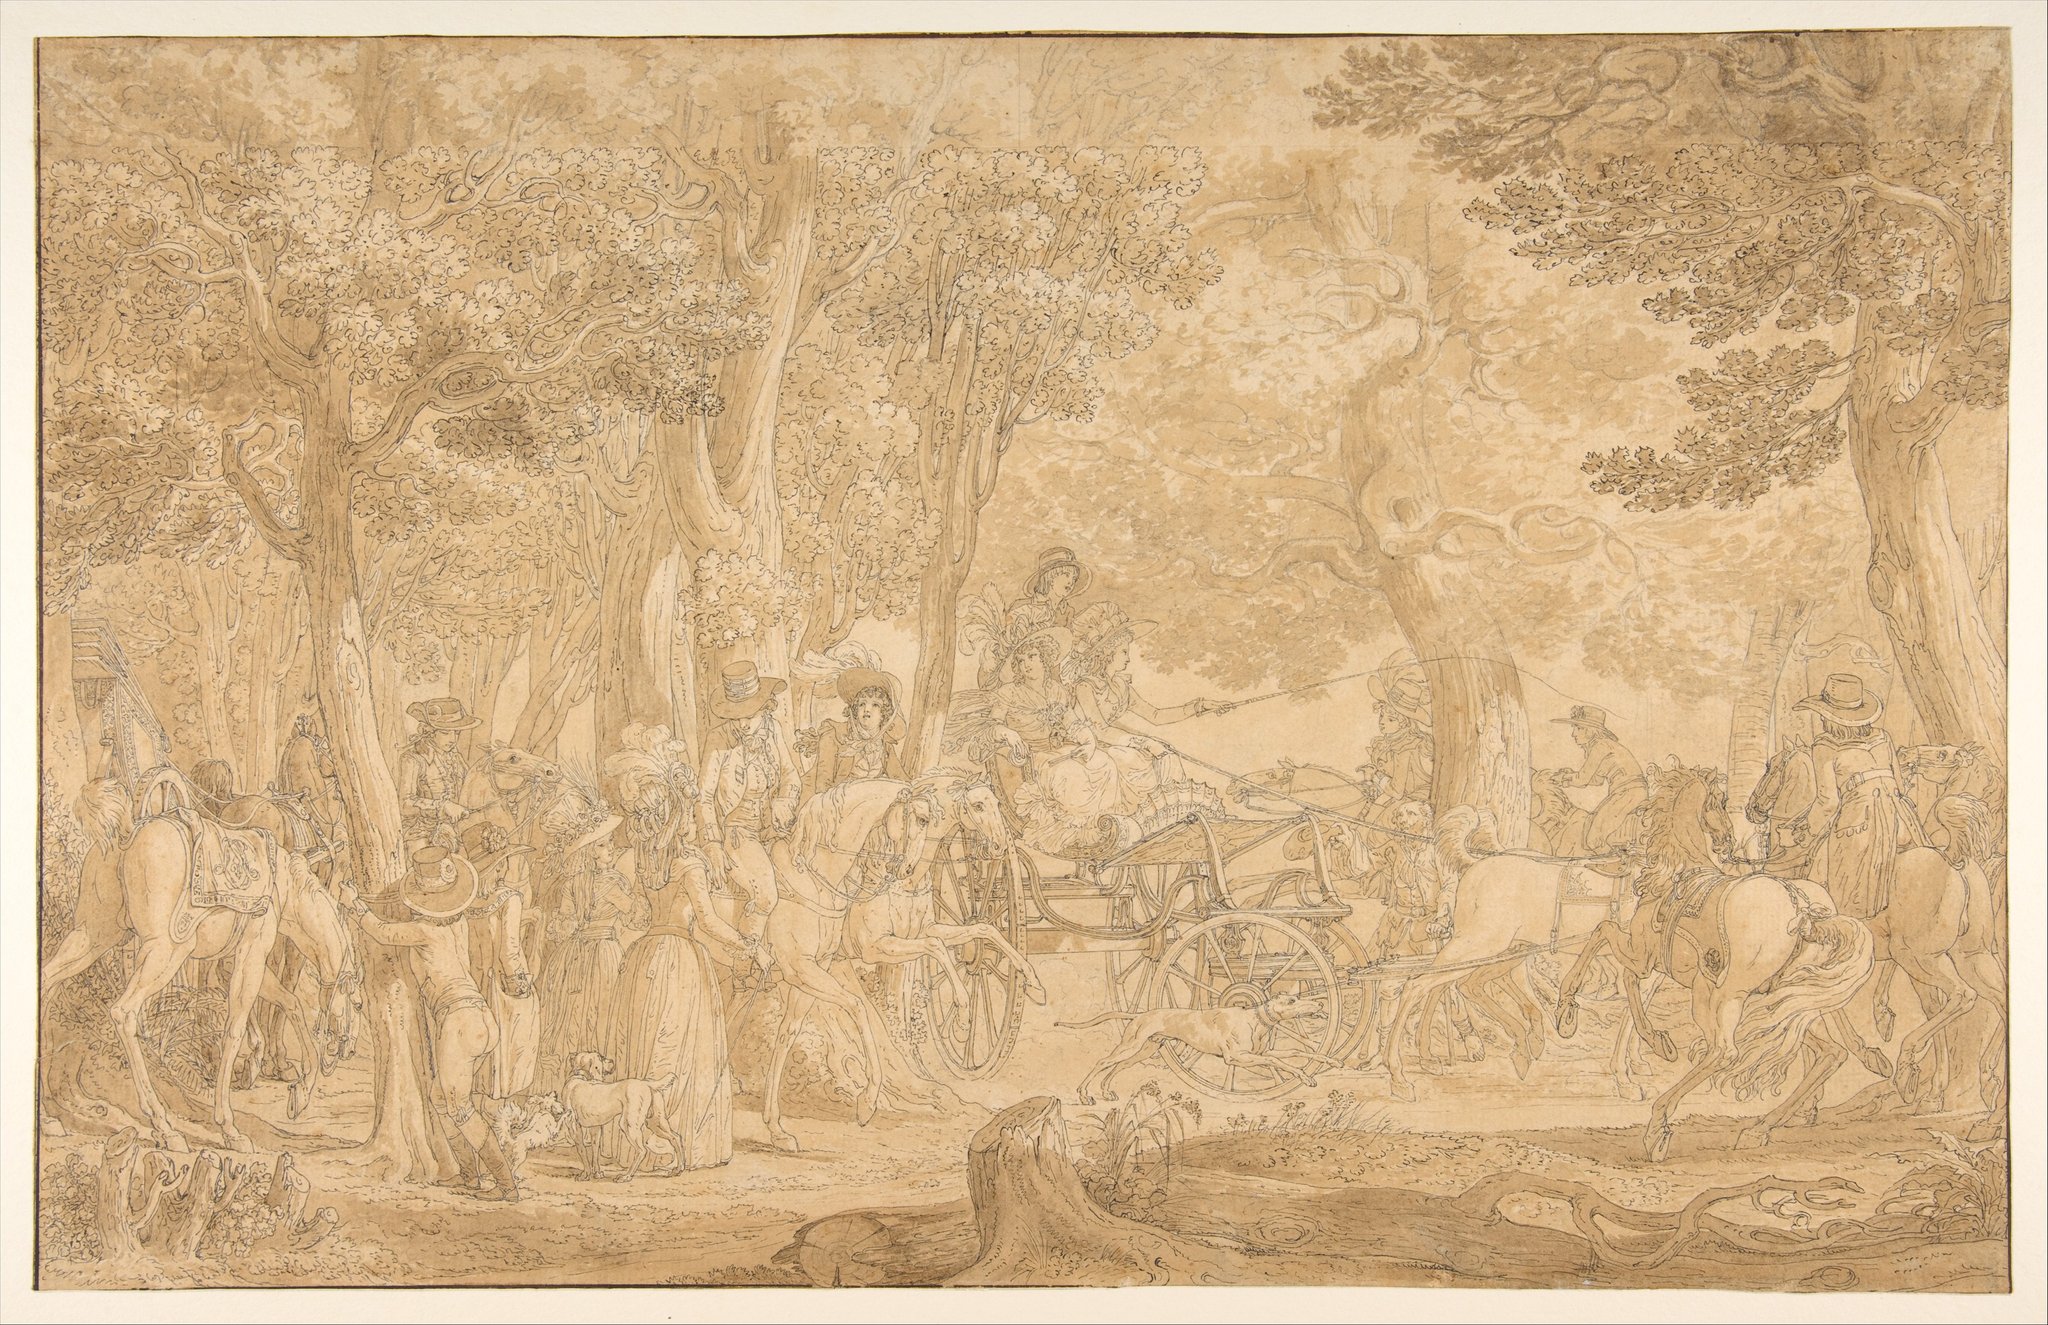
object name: drawing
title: Outing in a Wood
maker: jean michel moreau le jeune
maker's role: artist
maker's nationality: french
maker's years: 1741-1814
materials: chalk, ink, paper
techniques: pen, wash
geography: france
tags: men,women,horses,trees,carriages